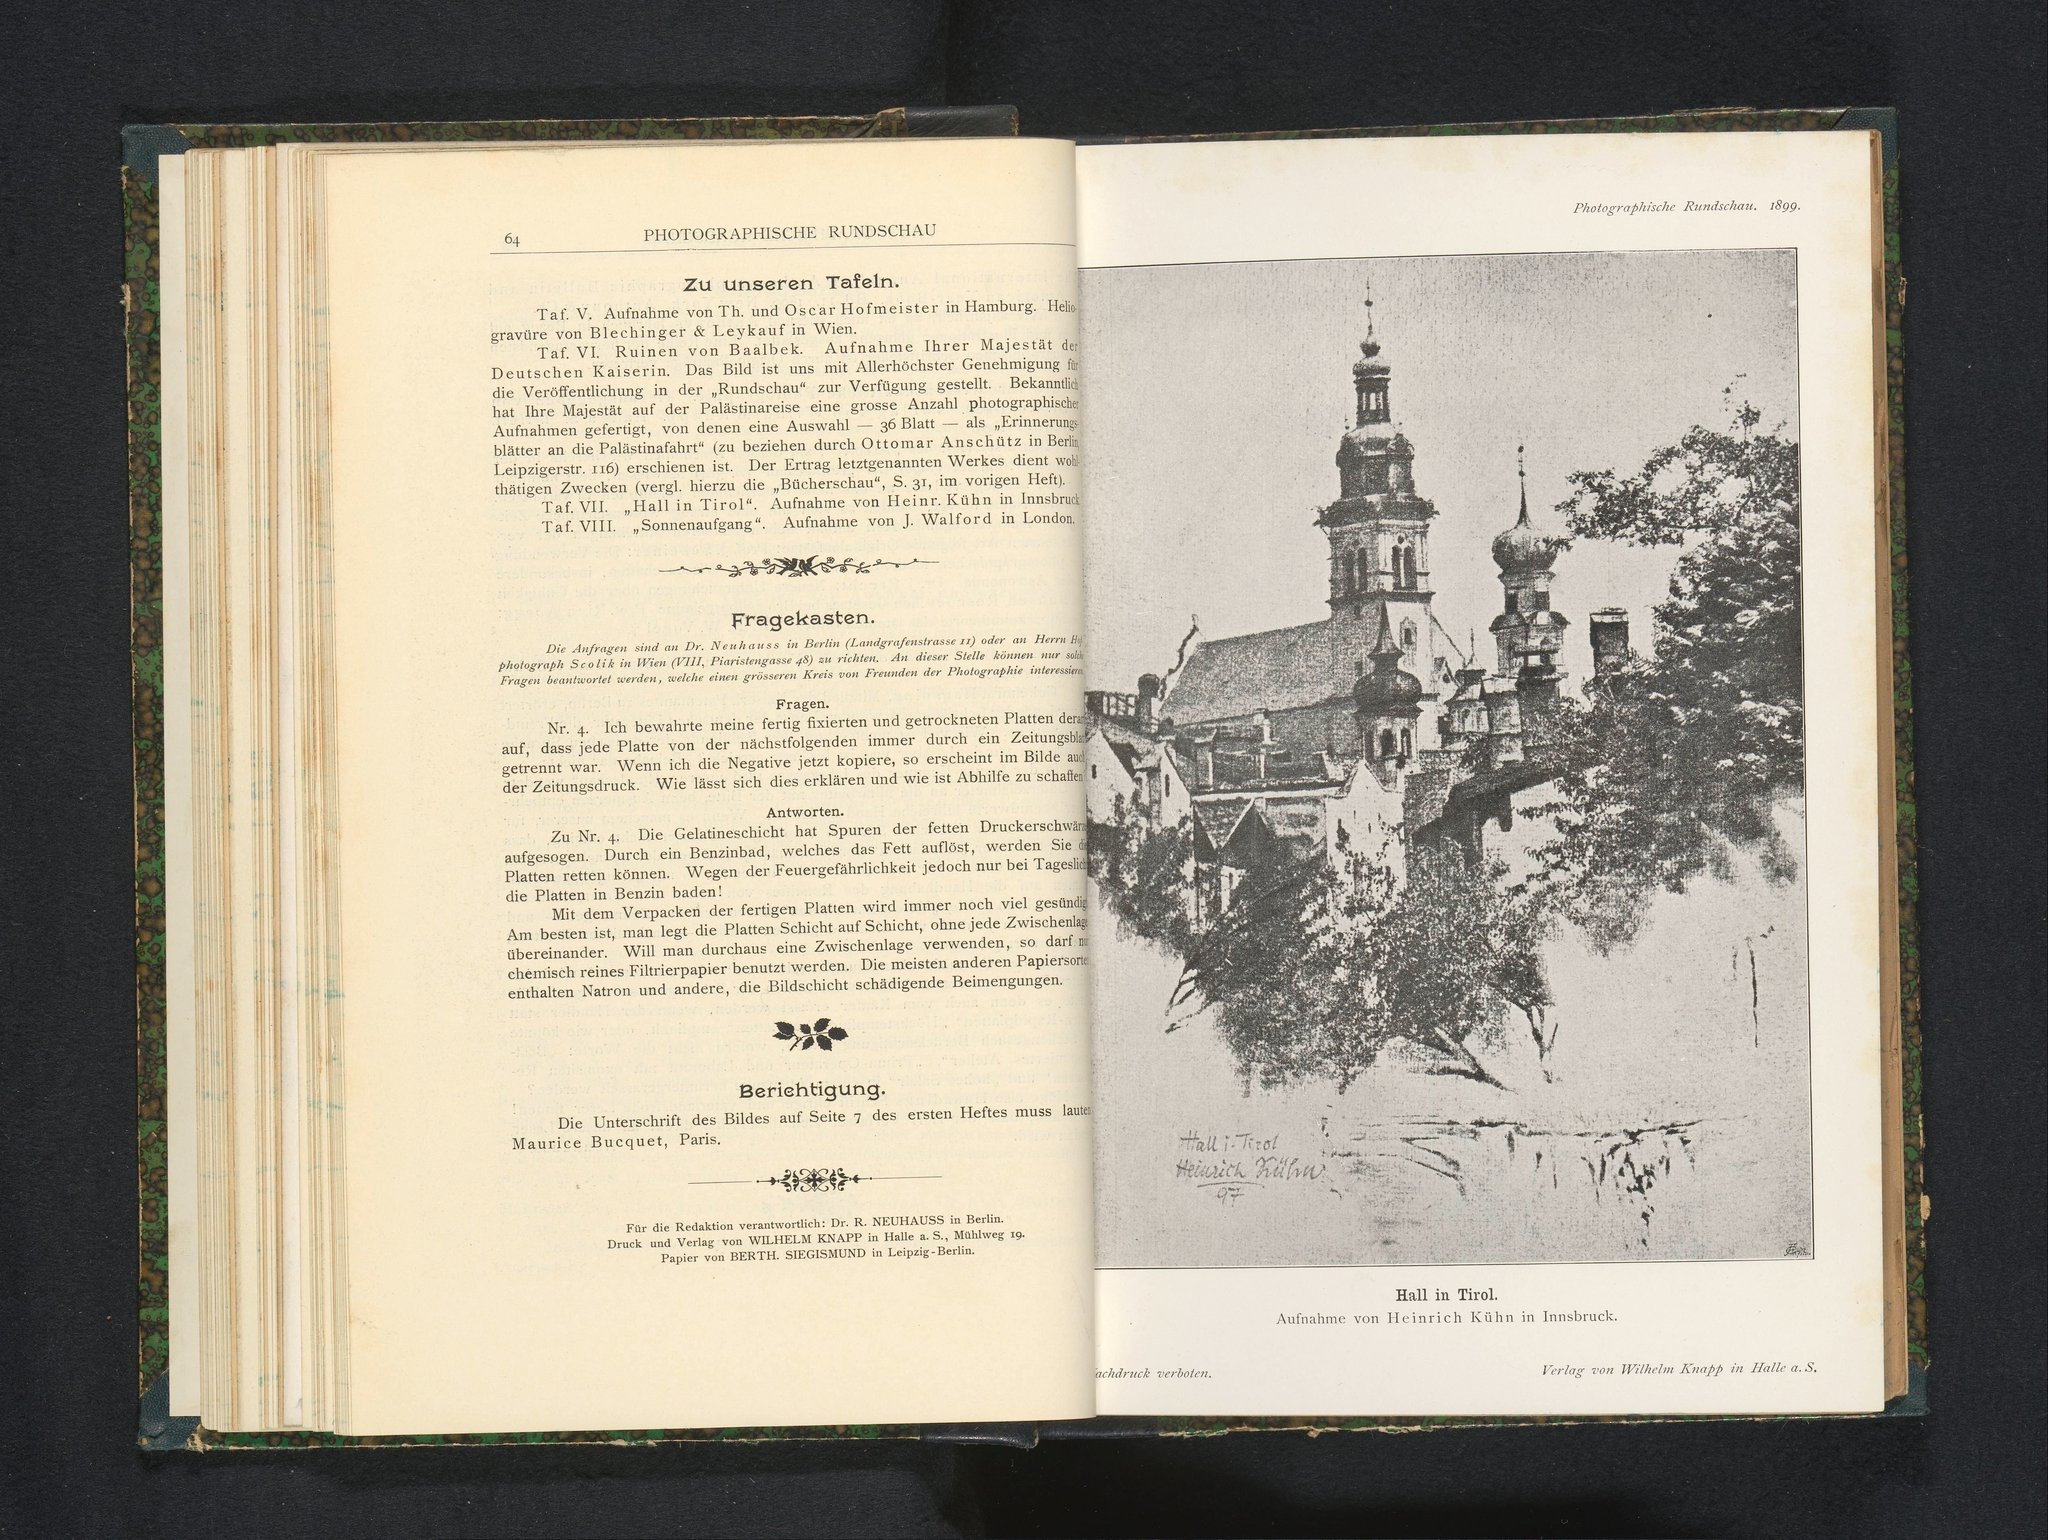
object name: page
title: Reproductie van een prent van een gezicht op de stad Hall in Tirol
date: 1897-1899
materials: paper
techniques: autotype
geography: halle an der saale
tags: city-view, and landscape with man-made constructions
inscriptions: monogram: ‘AG ph.’